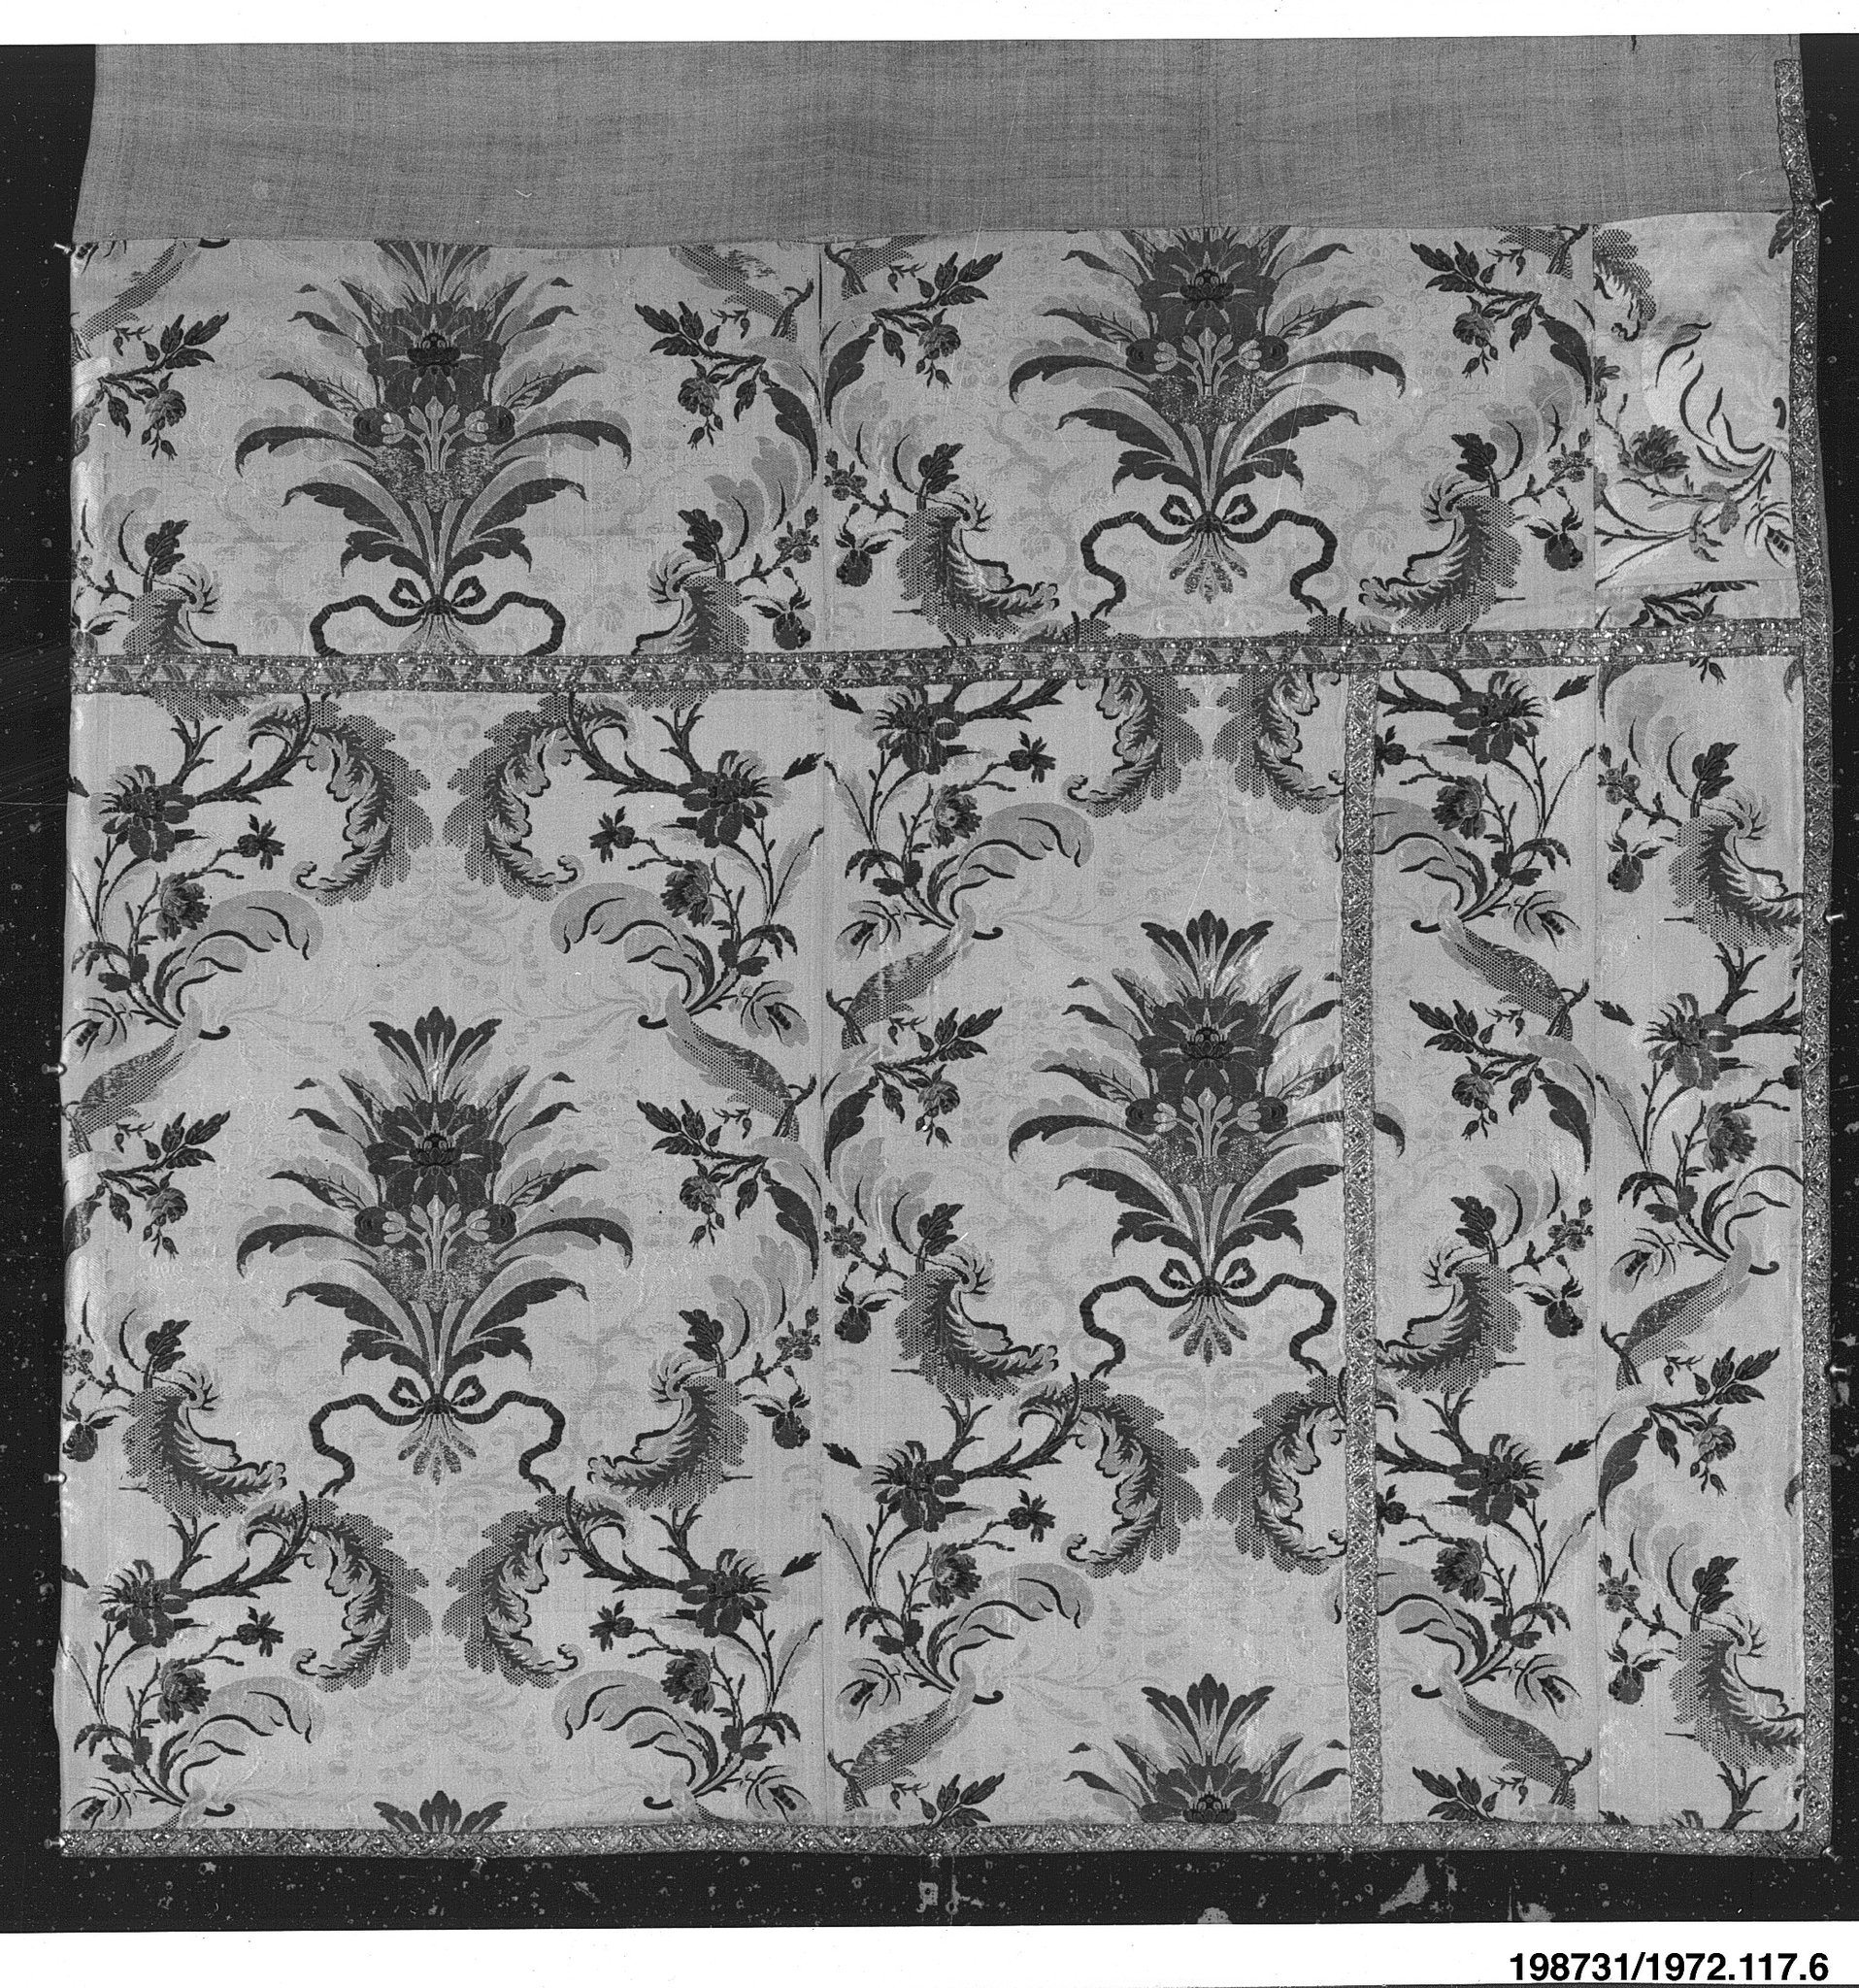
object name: altar frontal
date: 1701-1800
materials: metal thread, silk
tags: flowers